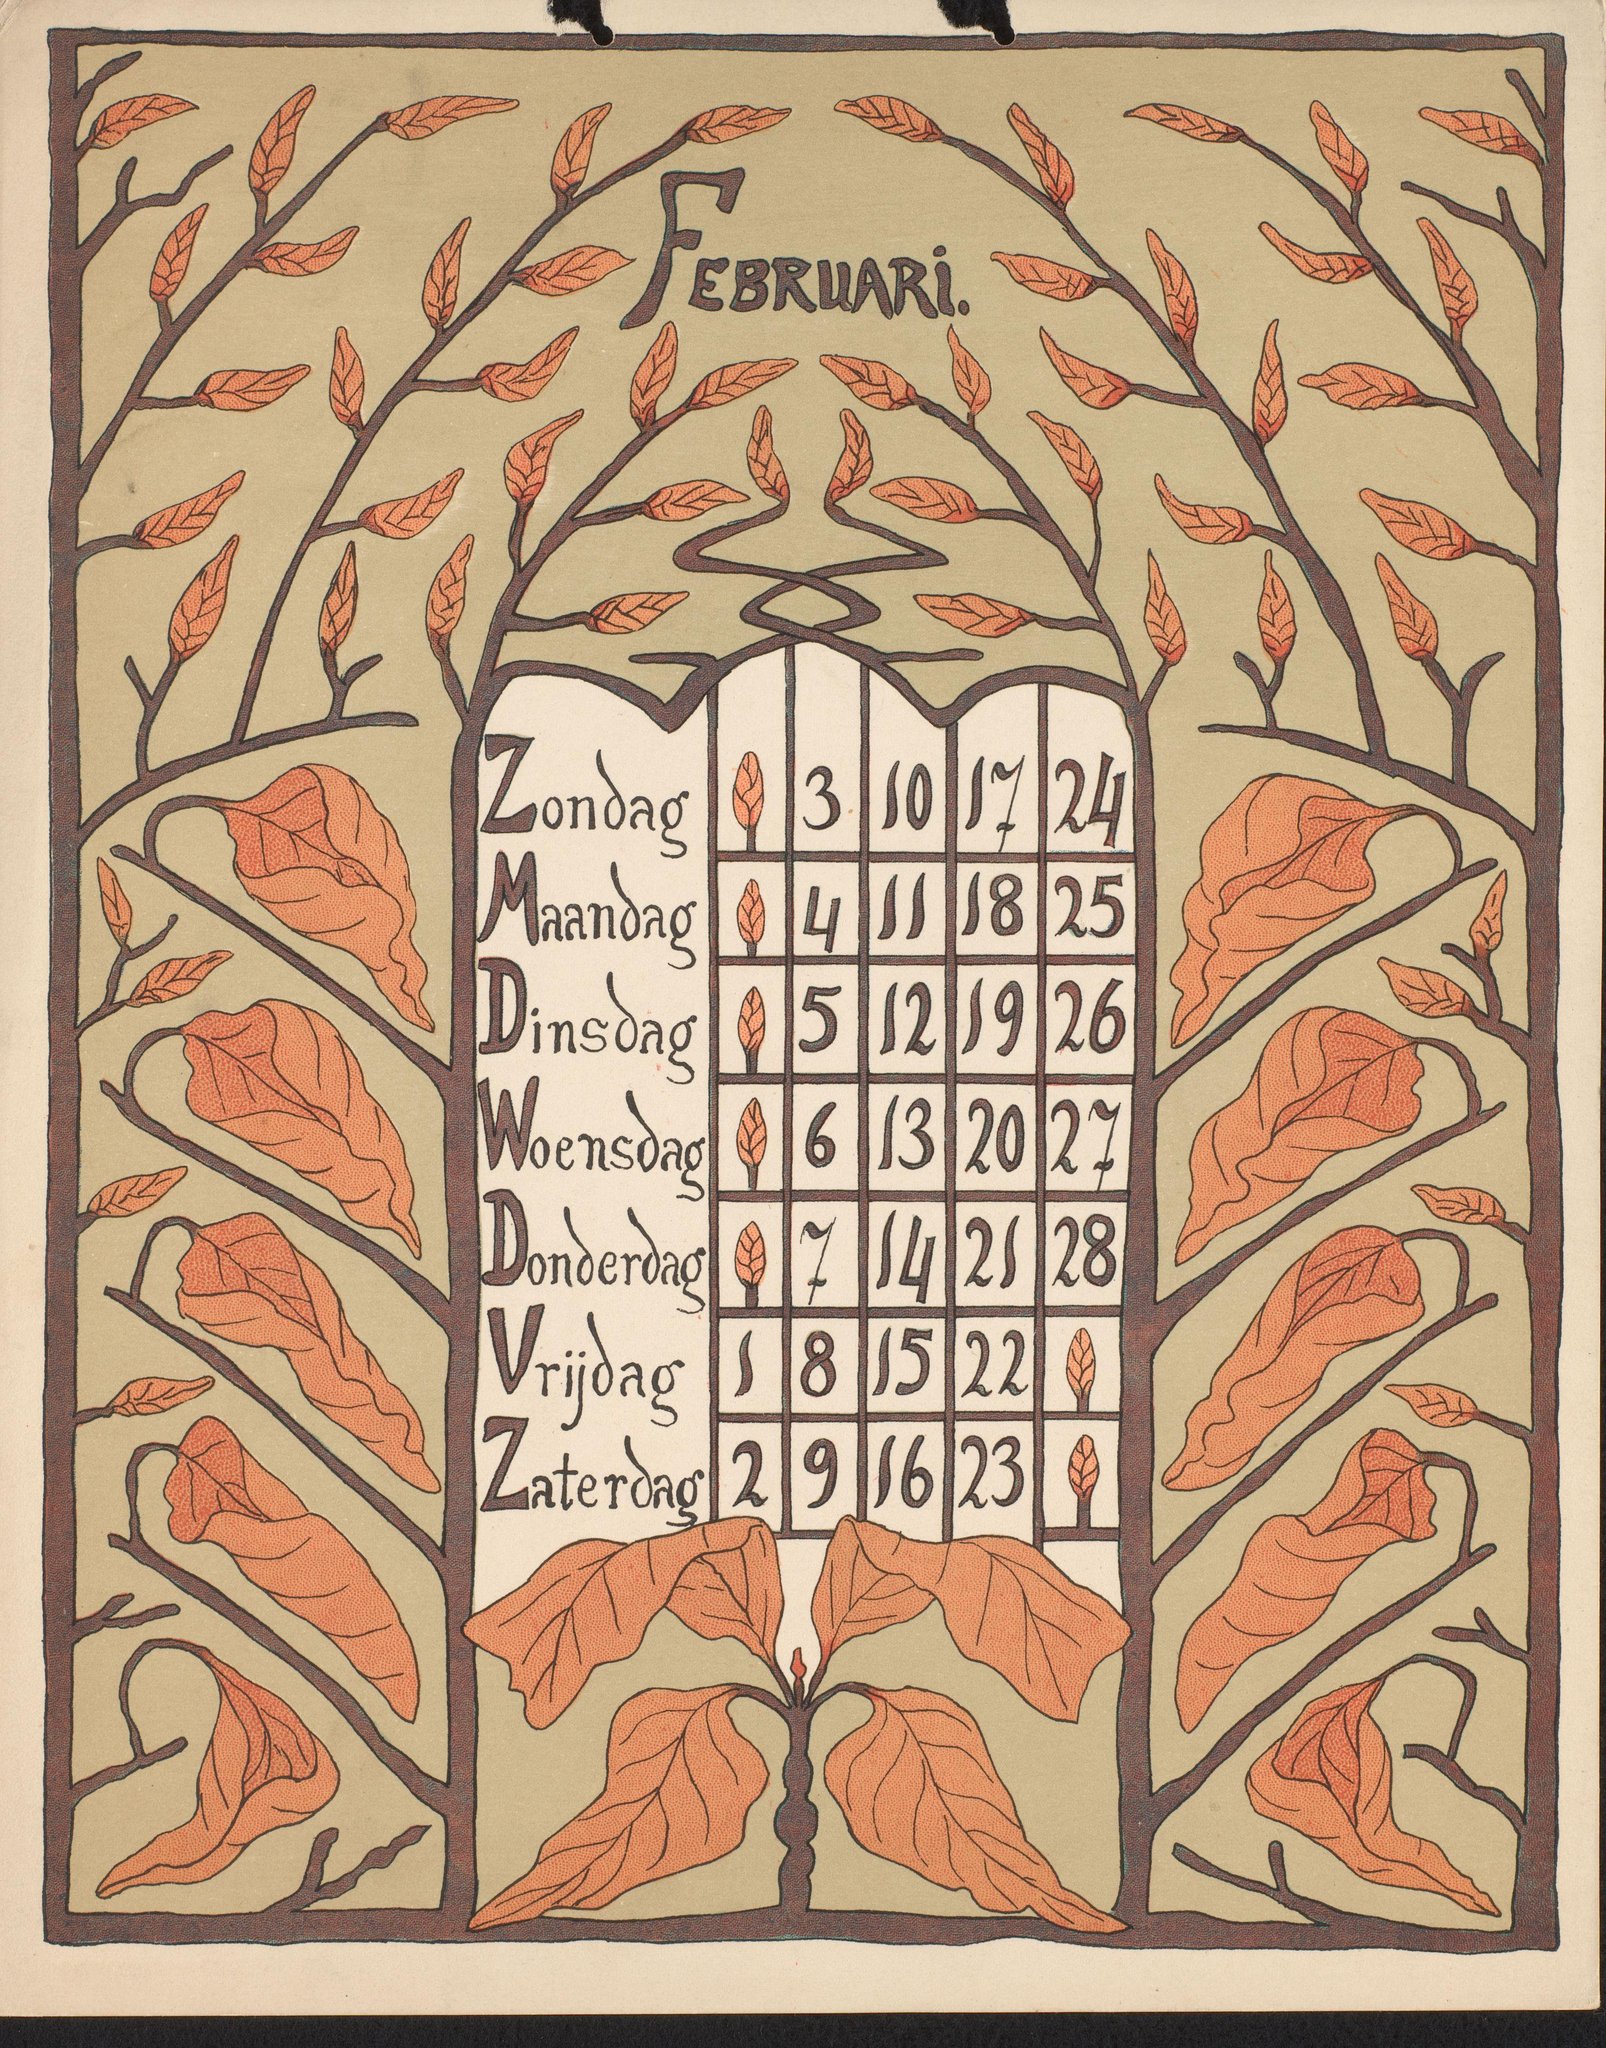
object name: print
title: Kalenderblad voor februari 1901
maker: c.a.j. van dishoeck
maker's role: publisher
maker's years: 1863-1931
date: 1900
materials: paper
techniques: lithograph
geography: amsterdam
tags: ornaments ~ art, calendar, almanac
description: Kalenderblad voor februari 1901 van de kalender 'Bloem en Blad', met een randdecoratie van uitkomende bladeren en bladknoppen aan takken.